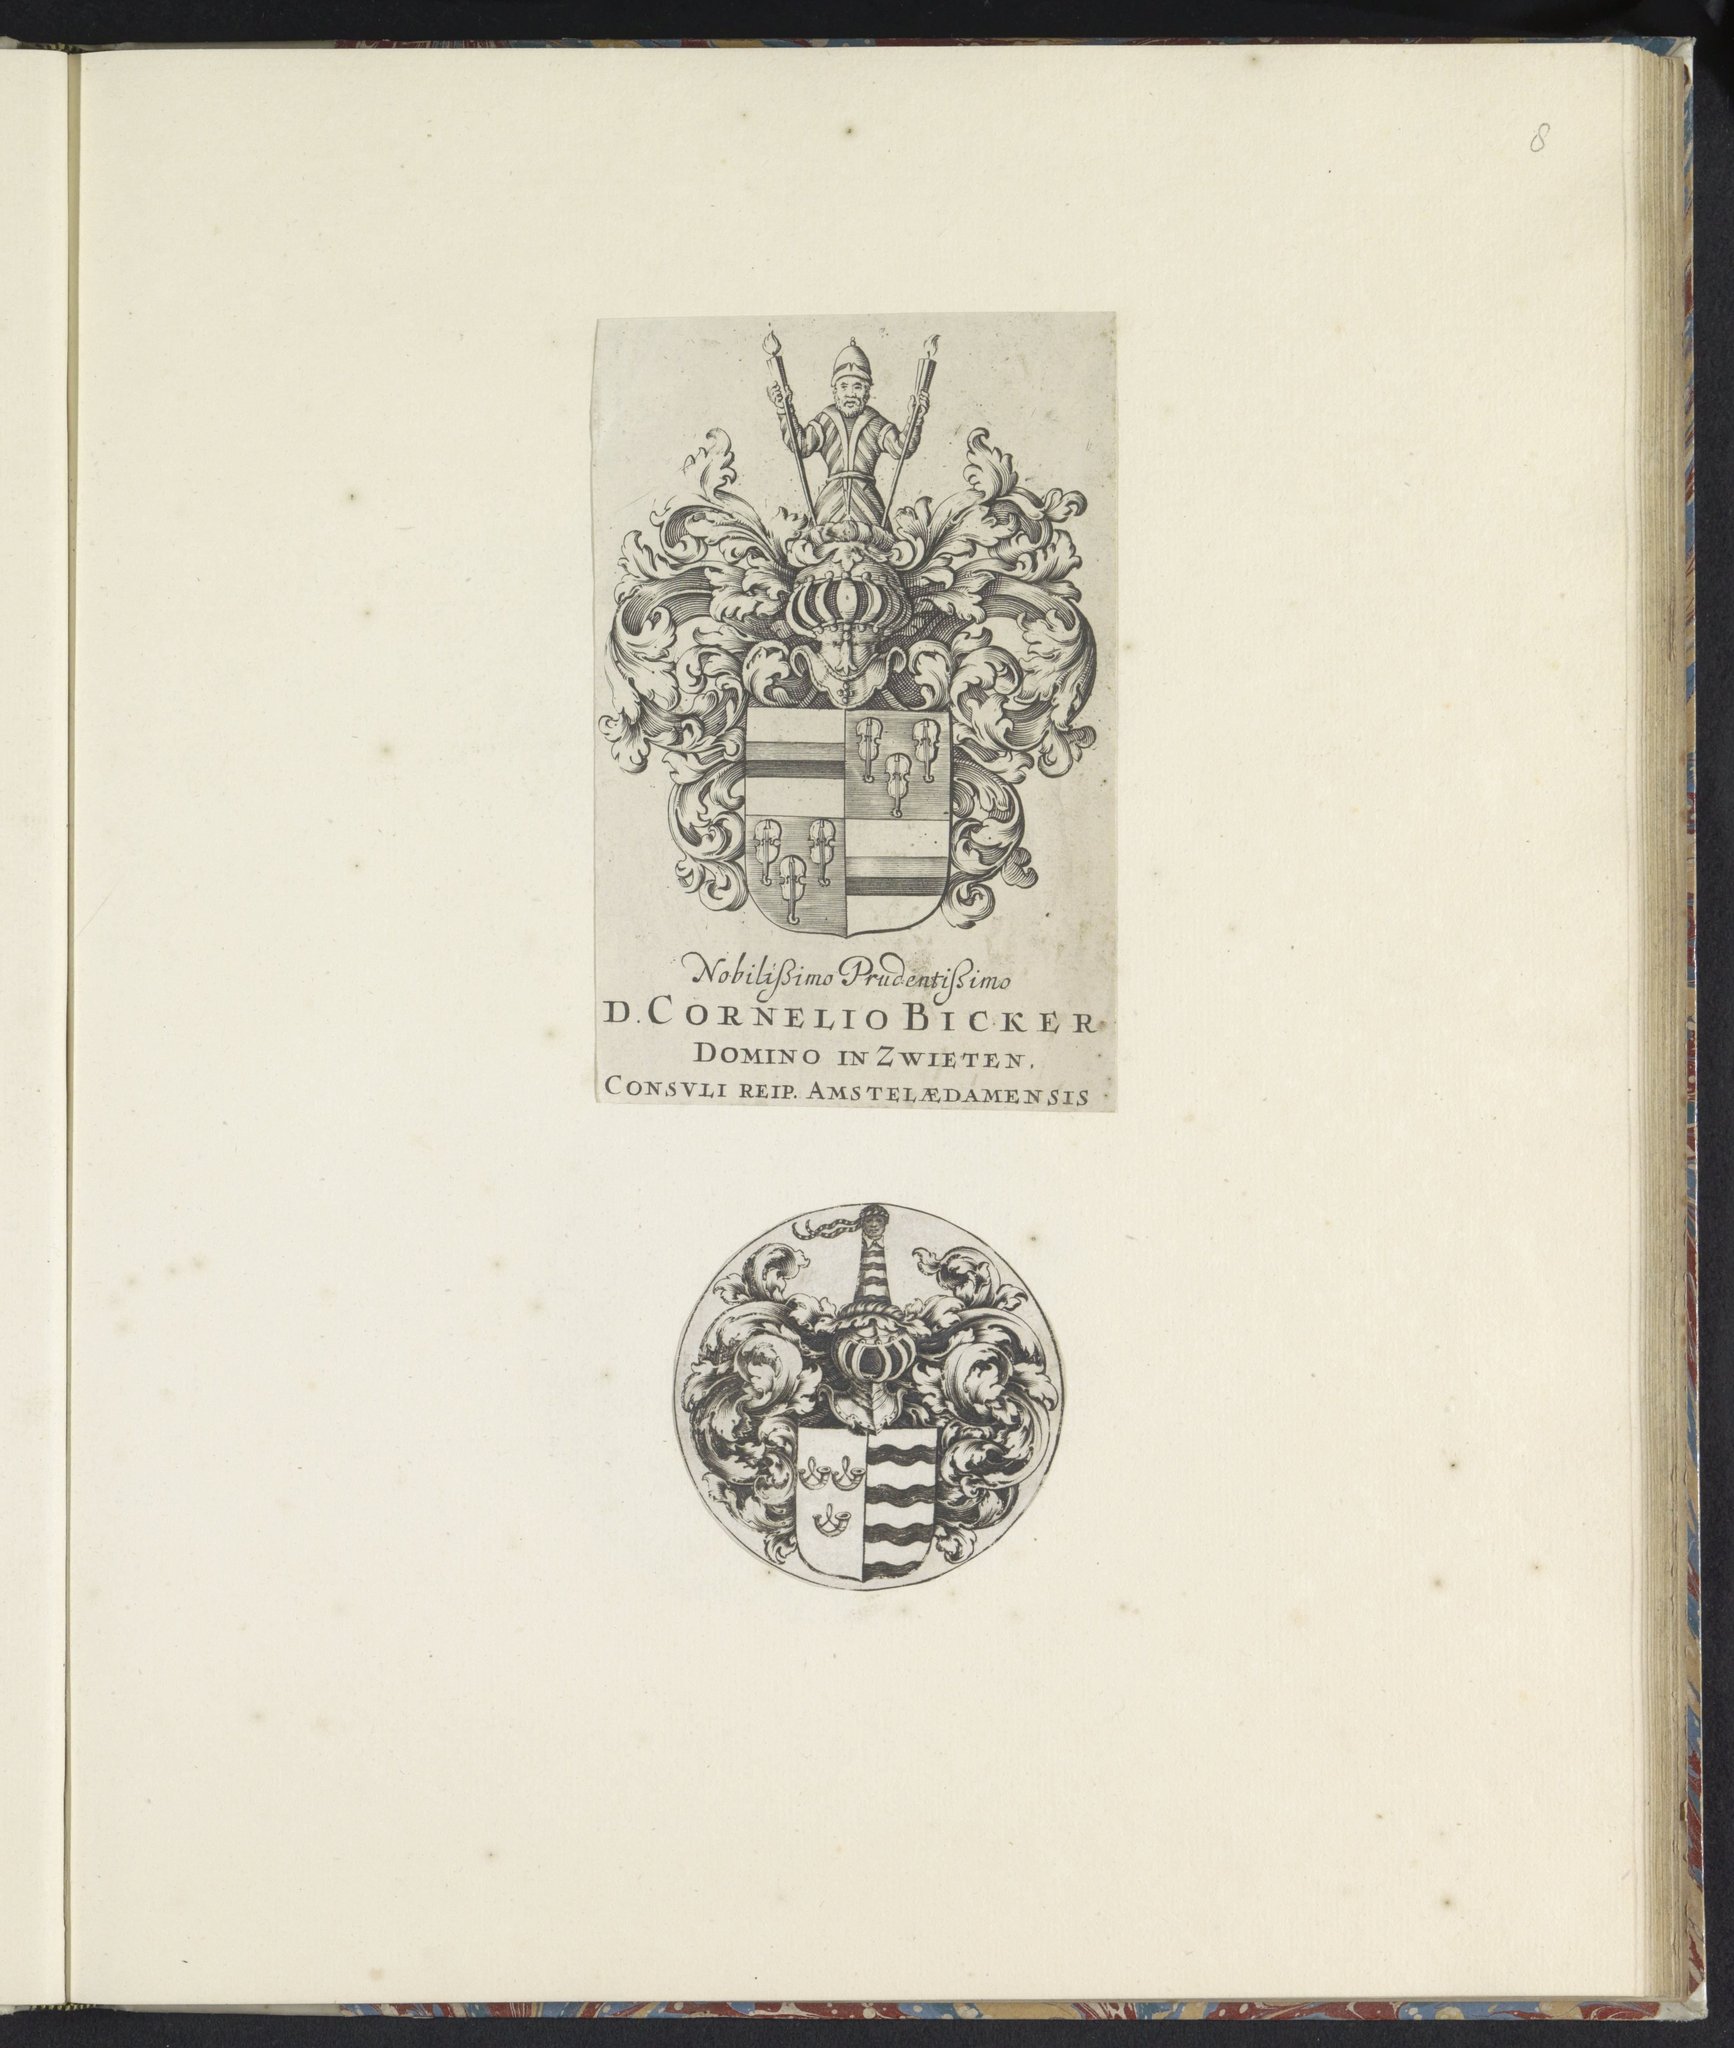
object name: print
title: Twee wapens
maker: Anonymous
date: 1611-1711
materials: paper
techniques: engraving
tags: amsterdam, mayor, horn, trumpet, cornet, trombone, tuba, violin, fiddle, armorial bearing, heraldry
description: Twee voorstellingen op een albumblad. Bovenaan het wapen van Cornelis Bicker, heer van Swieten. De voorstelling was oorspronkelijk onderdeel van de prent getiteld 'Amphitheatrum Vespasiani, nunc vulgo Il Coliseo'. Daaronder een nog niet geïdentificeerd wapen met drie hoorns en vier golven. Daarbij een Moor als helmteken. De prenten maken deel uit van een album.